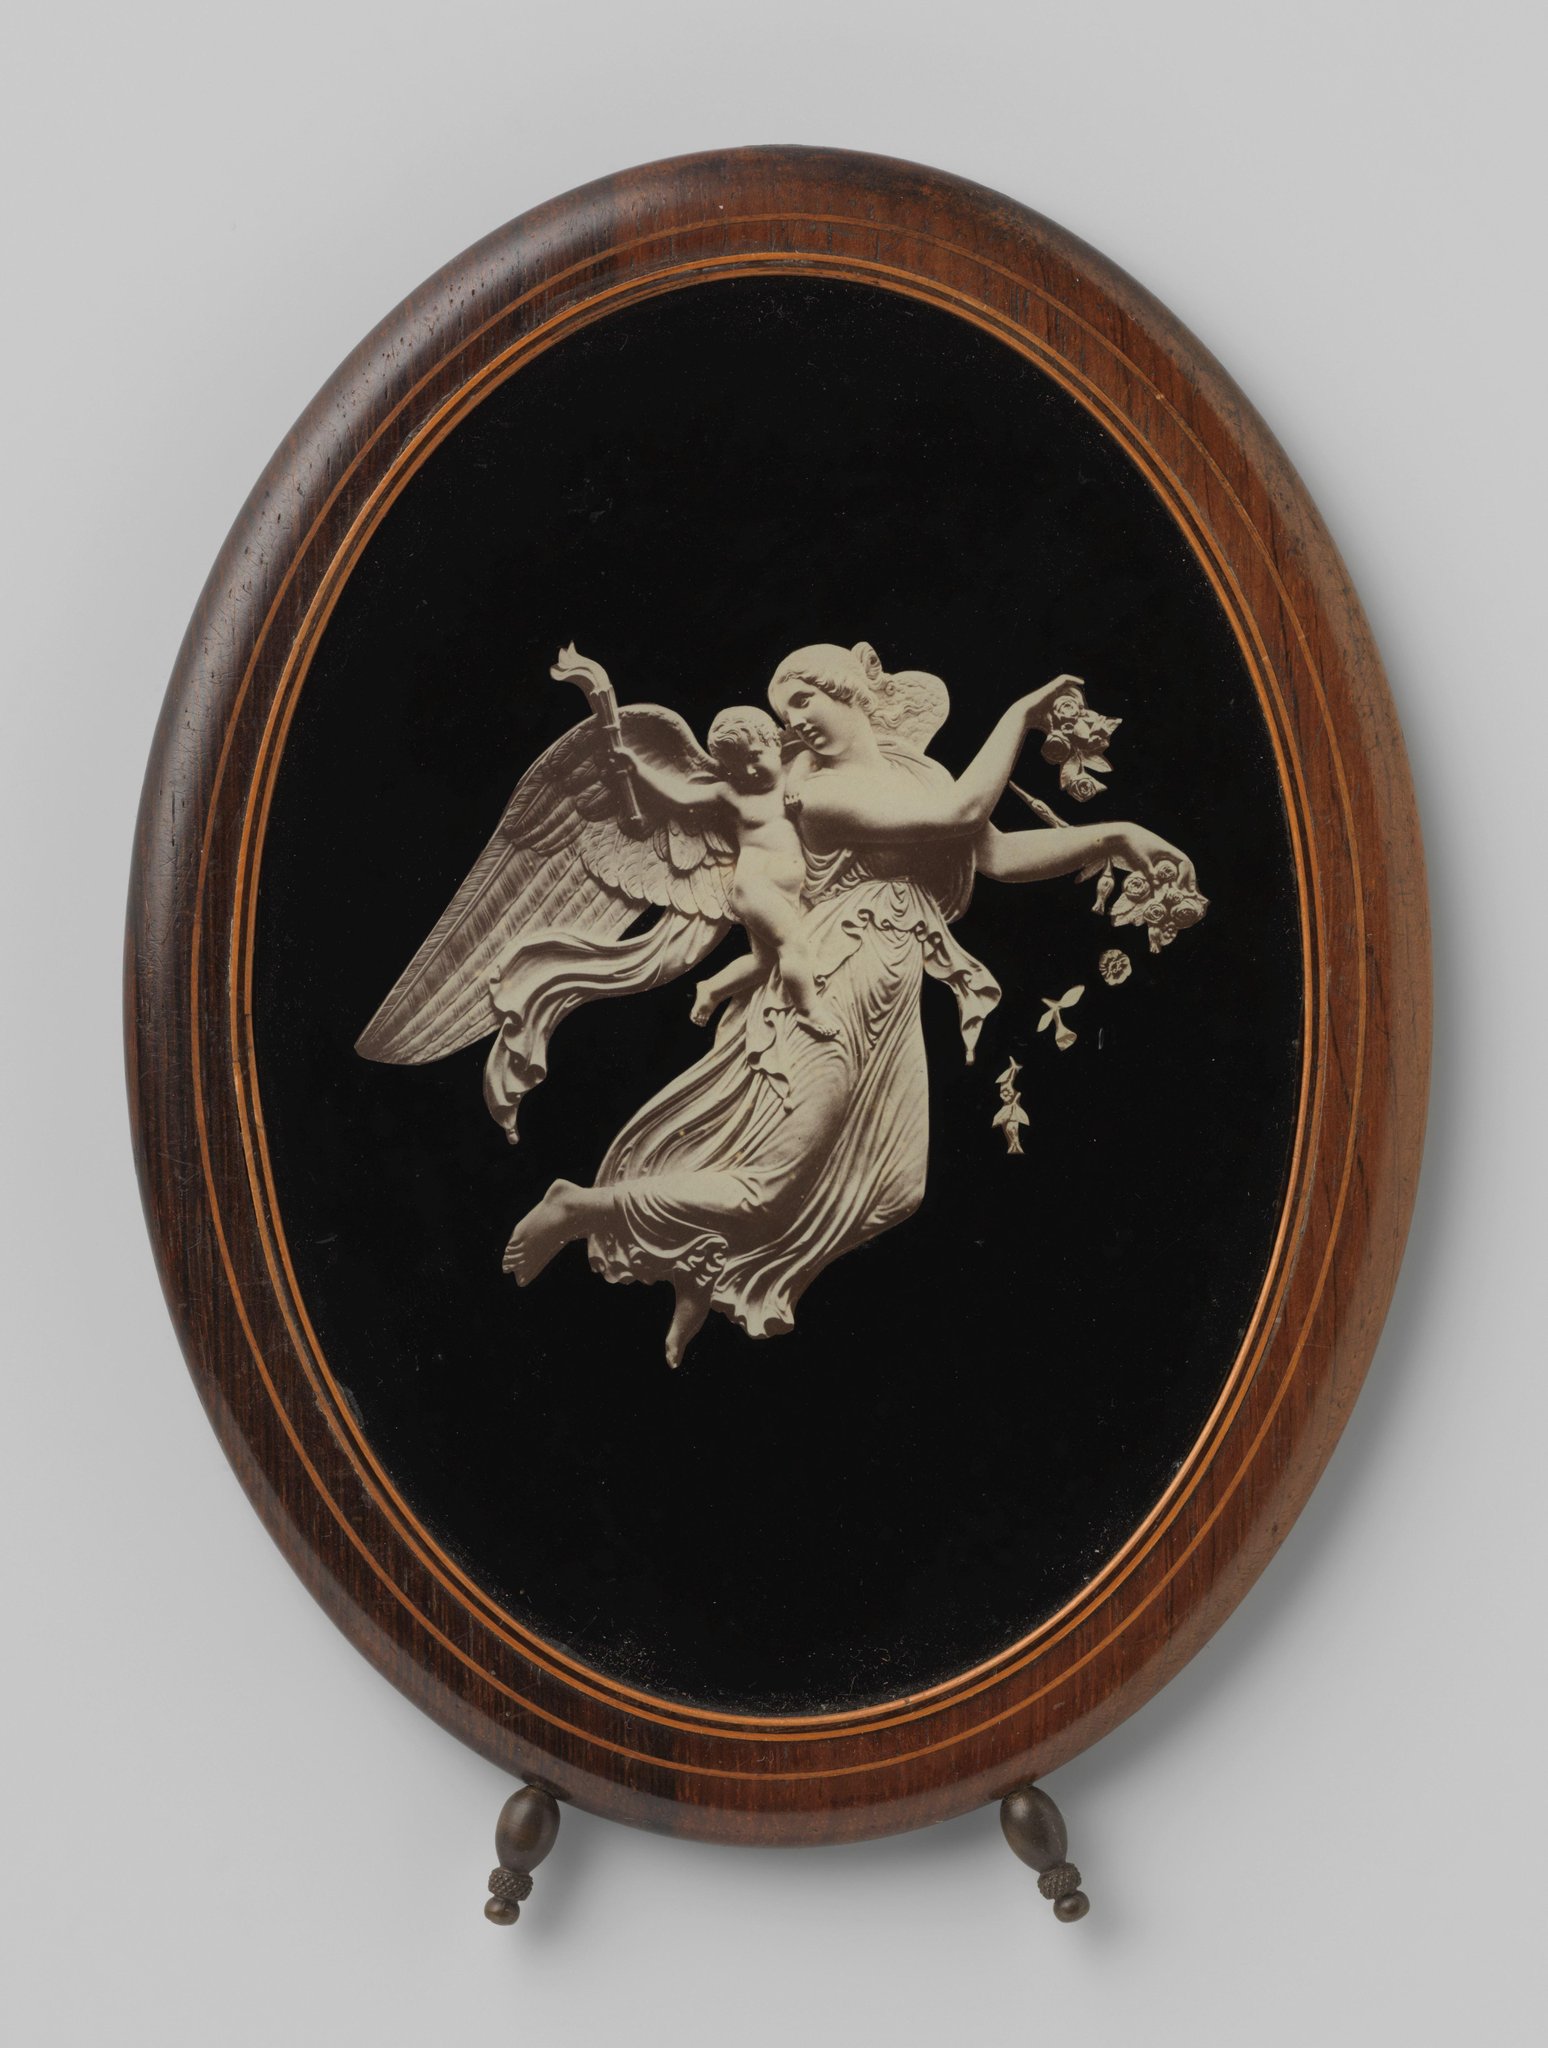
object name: photograph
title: Sculptuur van een beschermengel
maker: Anonymous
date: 1880-1900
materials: glass, lacquer, metal, paper, wood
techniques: albumen print, lacquer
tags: guardian angel, piece of sculpture, reproduction of a piece of sculpture